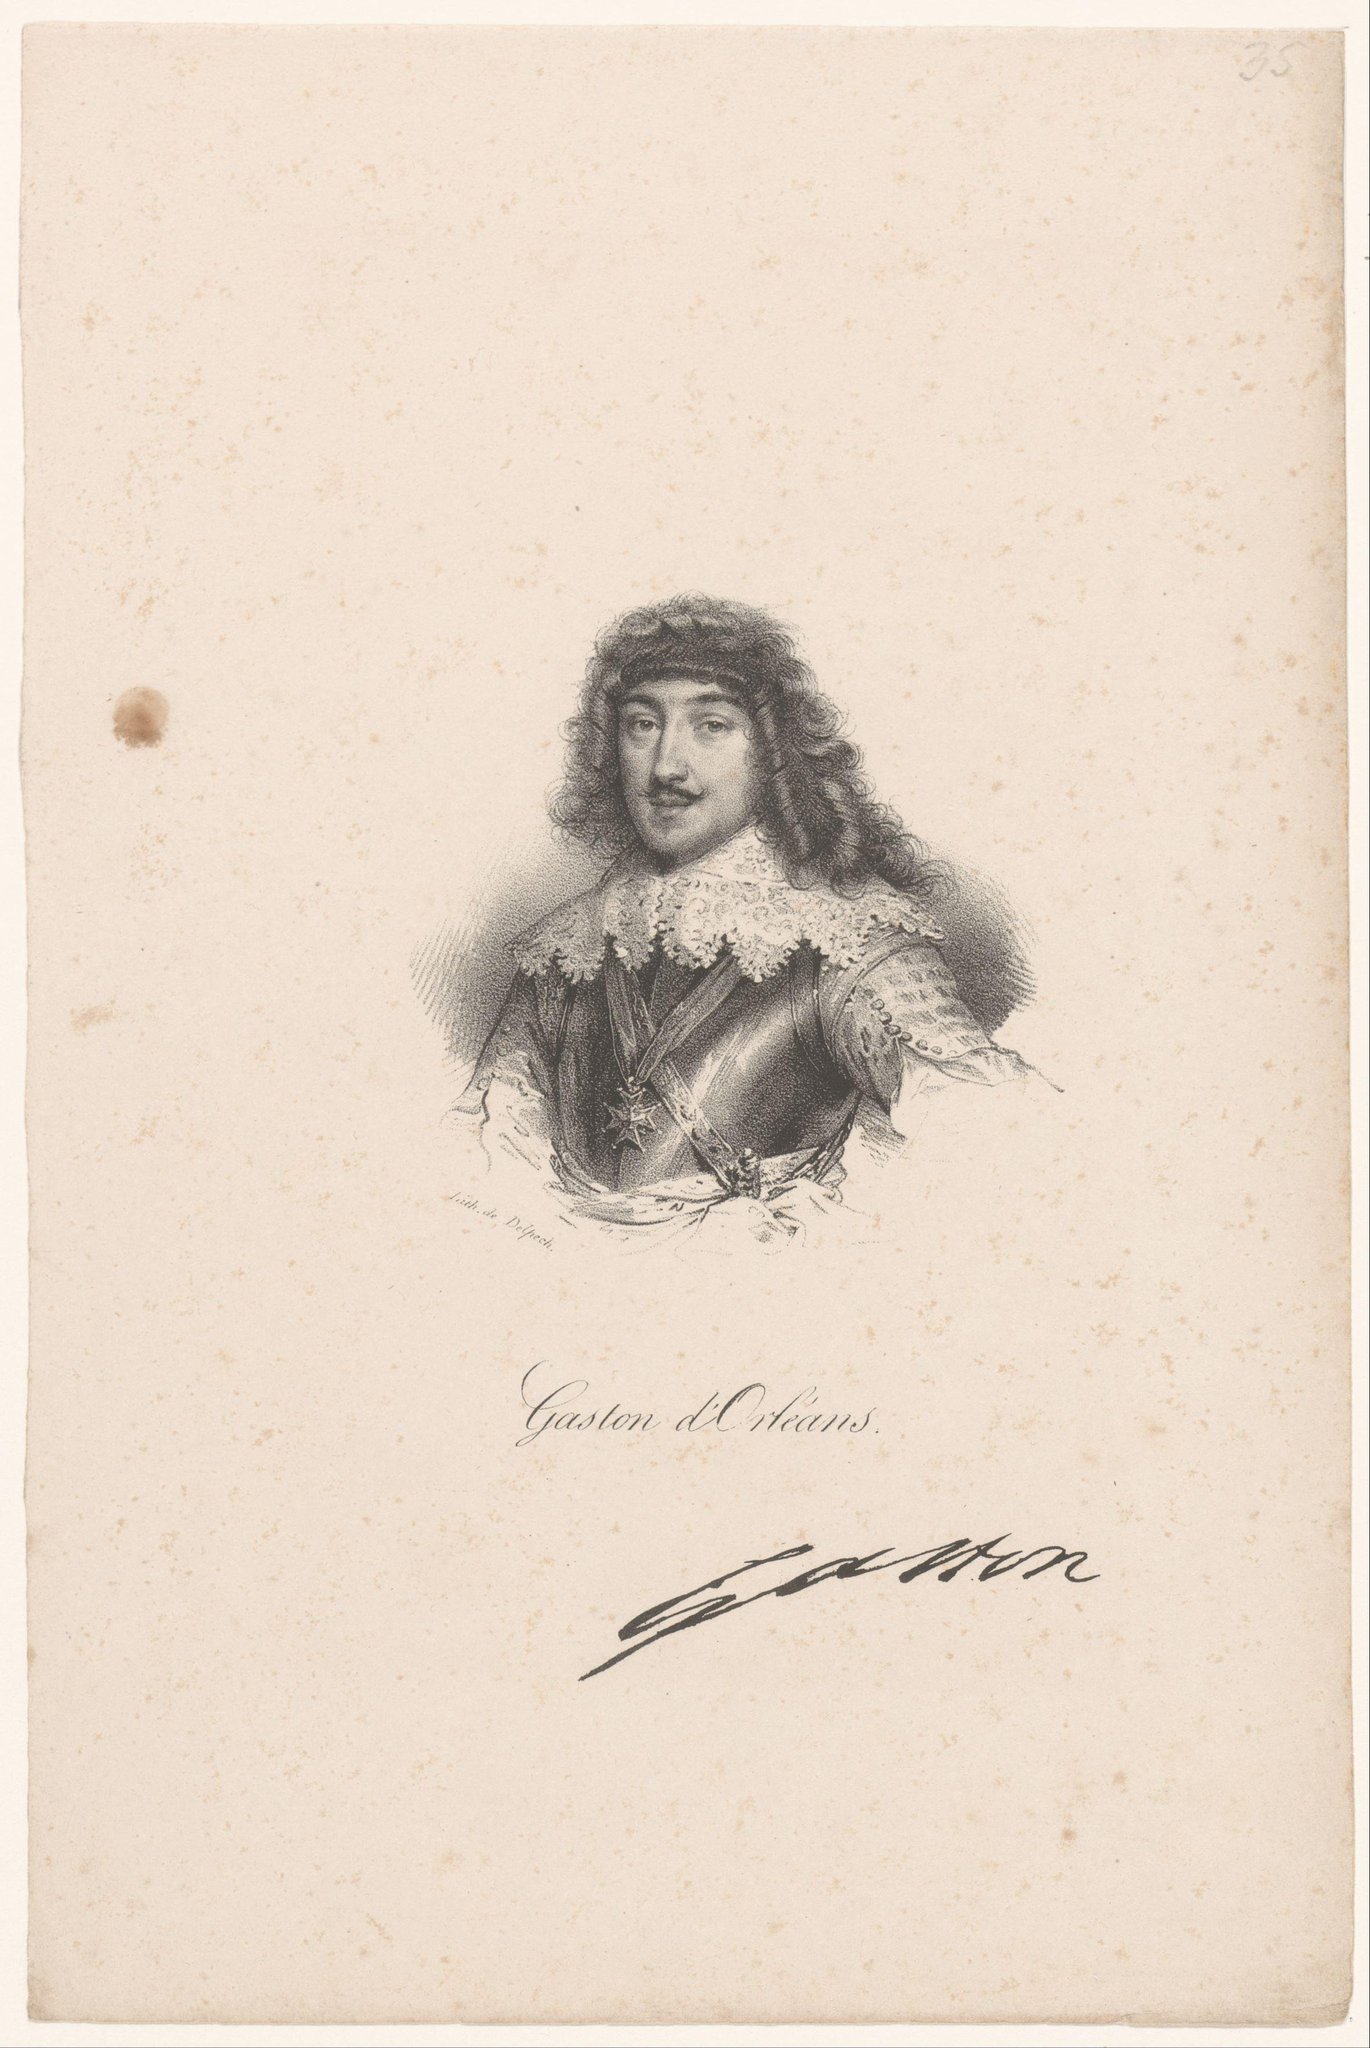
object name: print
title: Gaston d'Orléans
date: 1818-1842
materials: paper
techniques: lithograph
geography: paris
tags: gaston jean-baptiste hertog van orléans, historical persons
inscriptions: collector's mark: Lugt 2228a